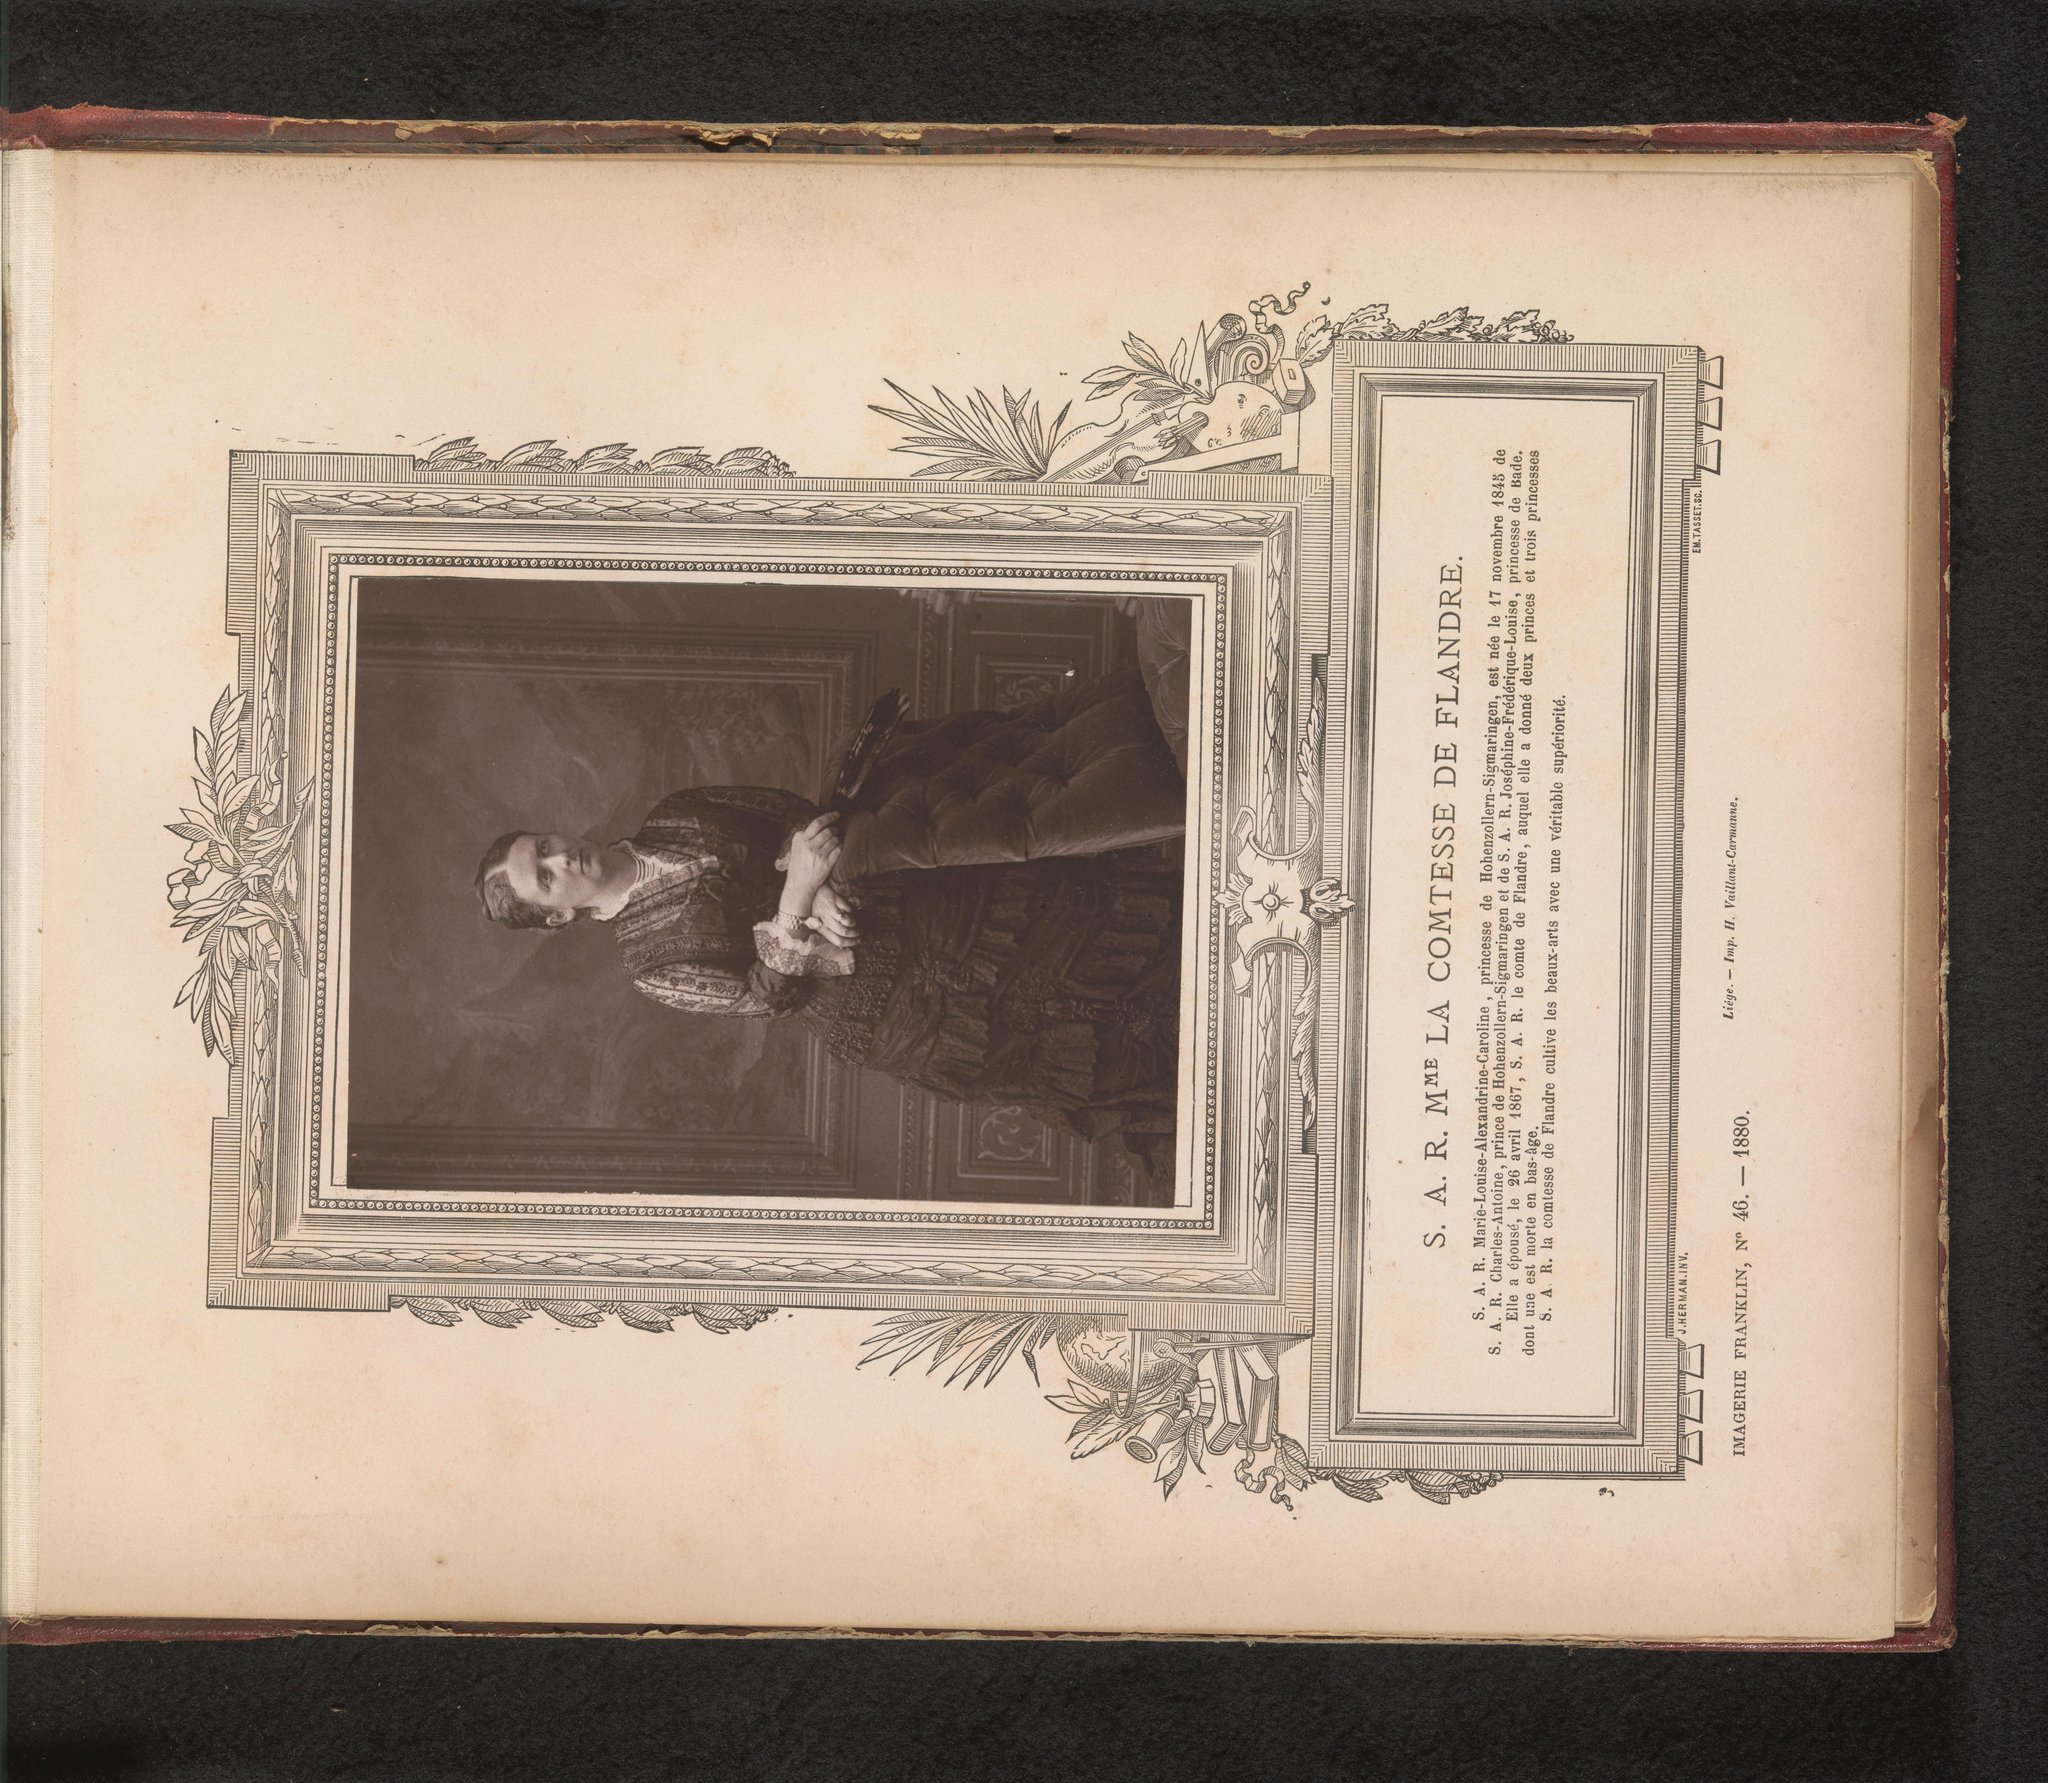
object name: photomechanical print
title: S. A. R. Mme la Comtesse de Flandre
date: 1875-1880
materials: paper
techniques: woodburytype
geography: liège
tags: brussels, print maker, maria van hohenzollern-sigmaringen (gravin van vlaanderen), historical persons - bb - woman, princess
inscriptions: inscription: ‘IMAGERIE FRANKLIN, No 46. - 1880.’, name: ‘EM. TASSET, SC.’, inscription: ‘S. A. R. Marie-Louise-Alexandrine-Caroline, (...) véritable supériorité.’, name: ‘J. HERMAN, INV.’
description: Deze prent maakt deel uit van een album.